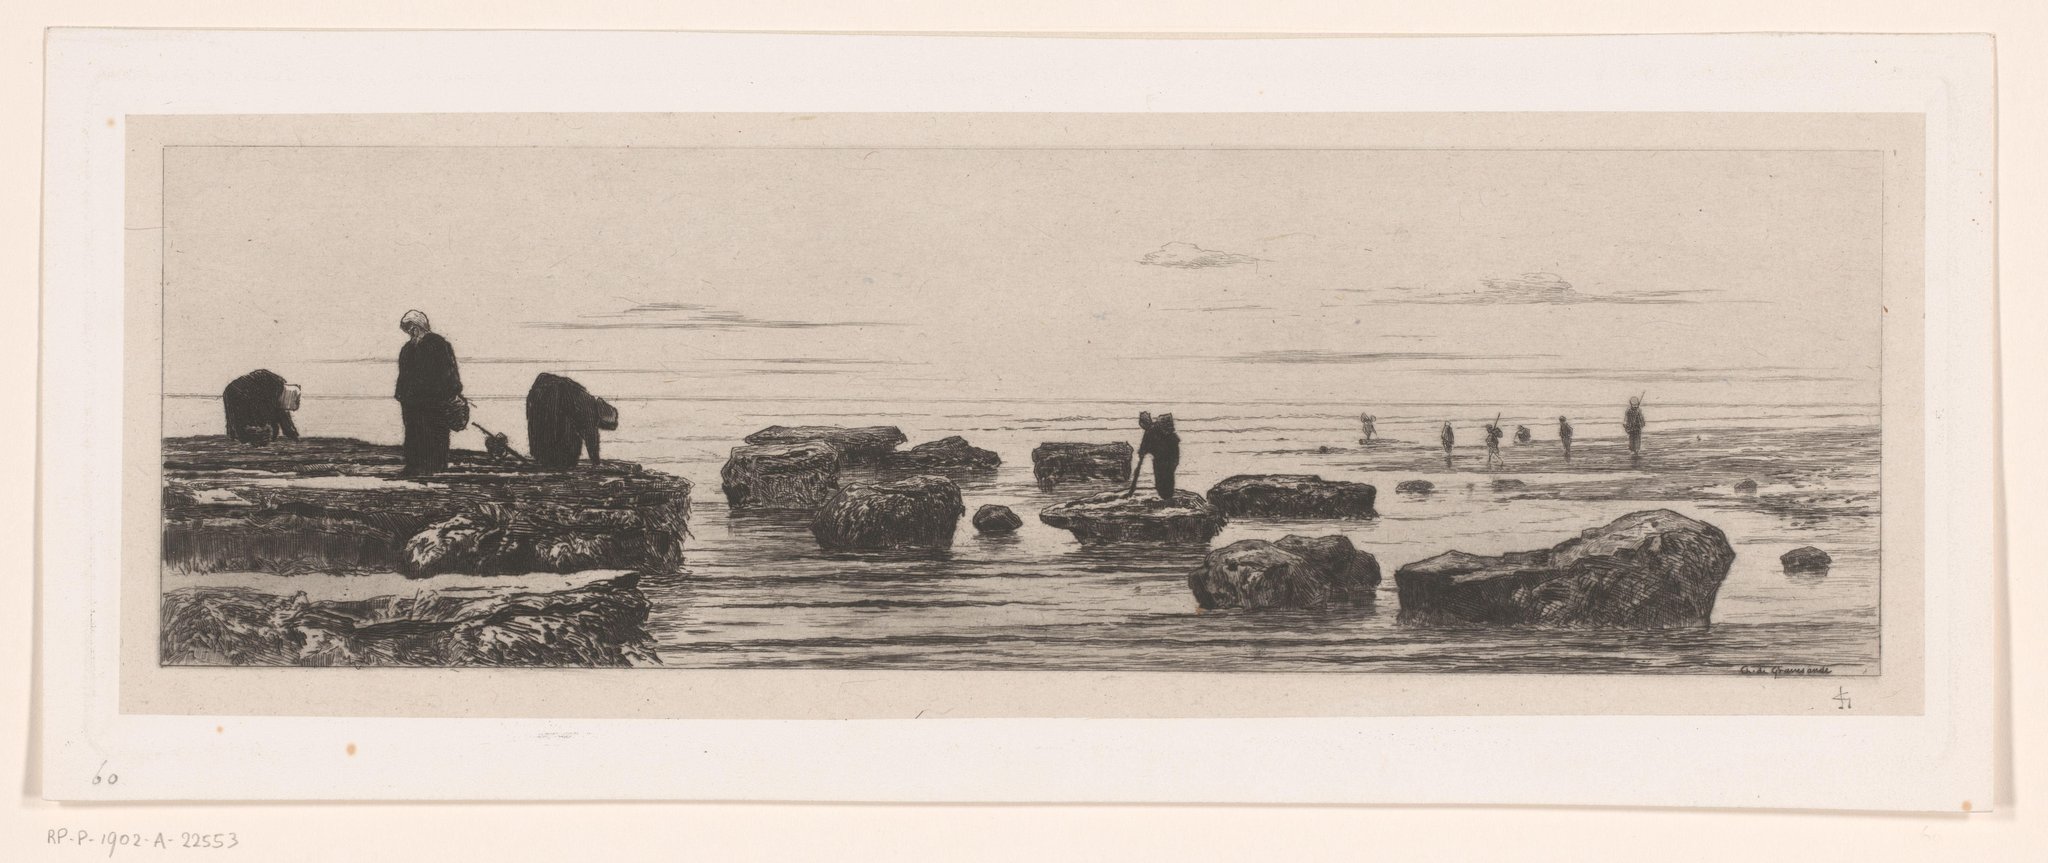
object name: print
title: Les ramasseurs de varech à Veules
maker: carel nicolaas storm van s-gravesande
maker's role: draughtsman, print maker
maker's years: 1841-1924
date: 1873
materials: paper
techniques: etching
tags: gathering herbs, beach (+ landscape with figures, staffage)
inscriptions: collector's mark: Lugt 2228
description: Gezicht op een strand met rotsblokken waar mensen zeewier aan het plukken zijn in de branding.